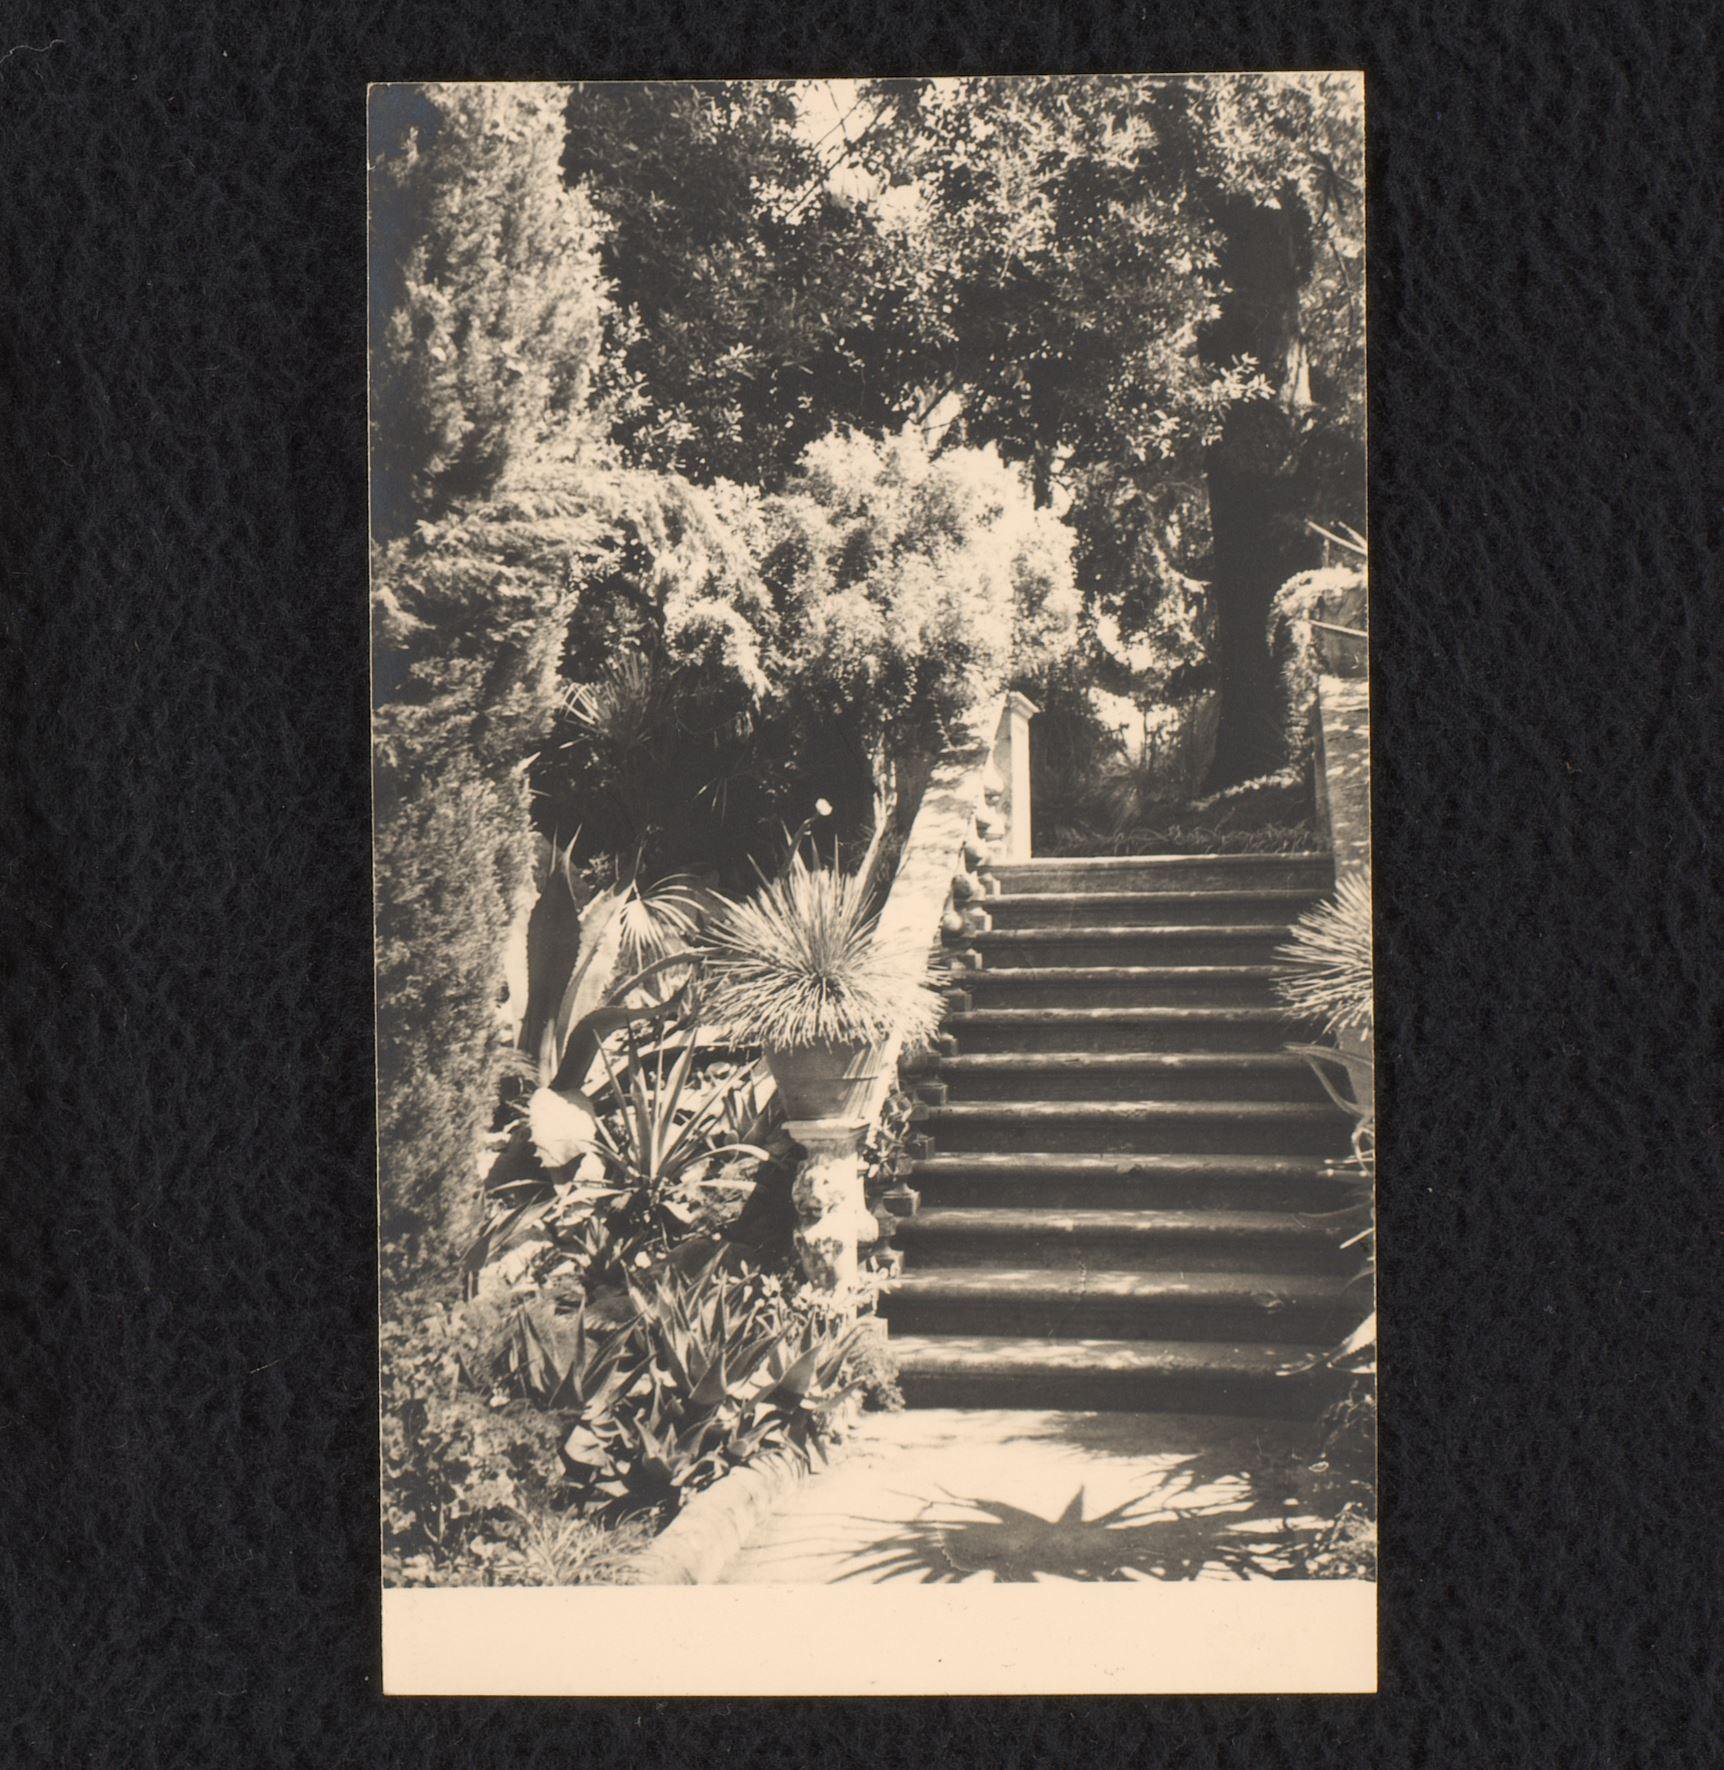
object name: ansichtkaart, prentbriefkaart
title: Trap in de tuin van Villa Tritone, Sorrento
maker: Anonymous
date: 1930-1950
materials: paper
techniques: gelatin silver print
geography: sorrento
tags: garden, staircase